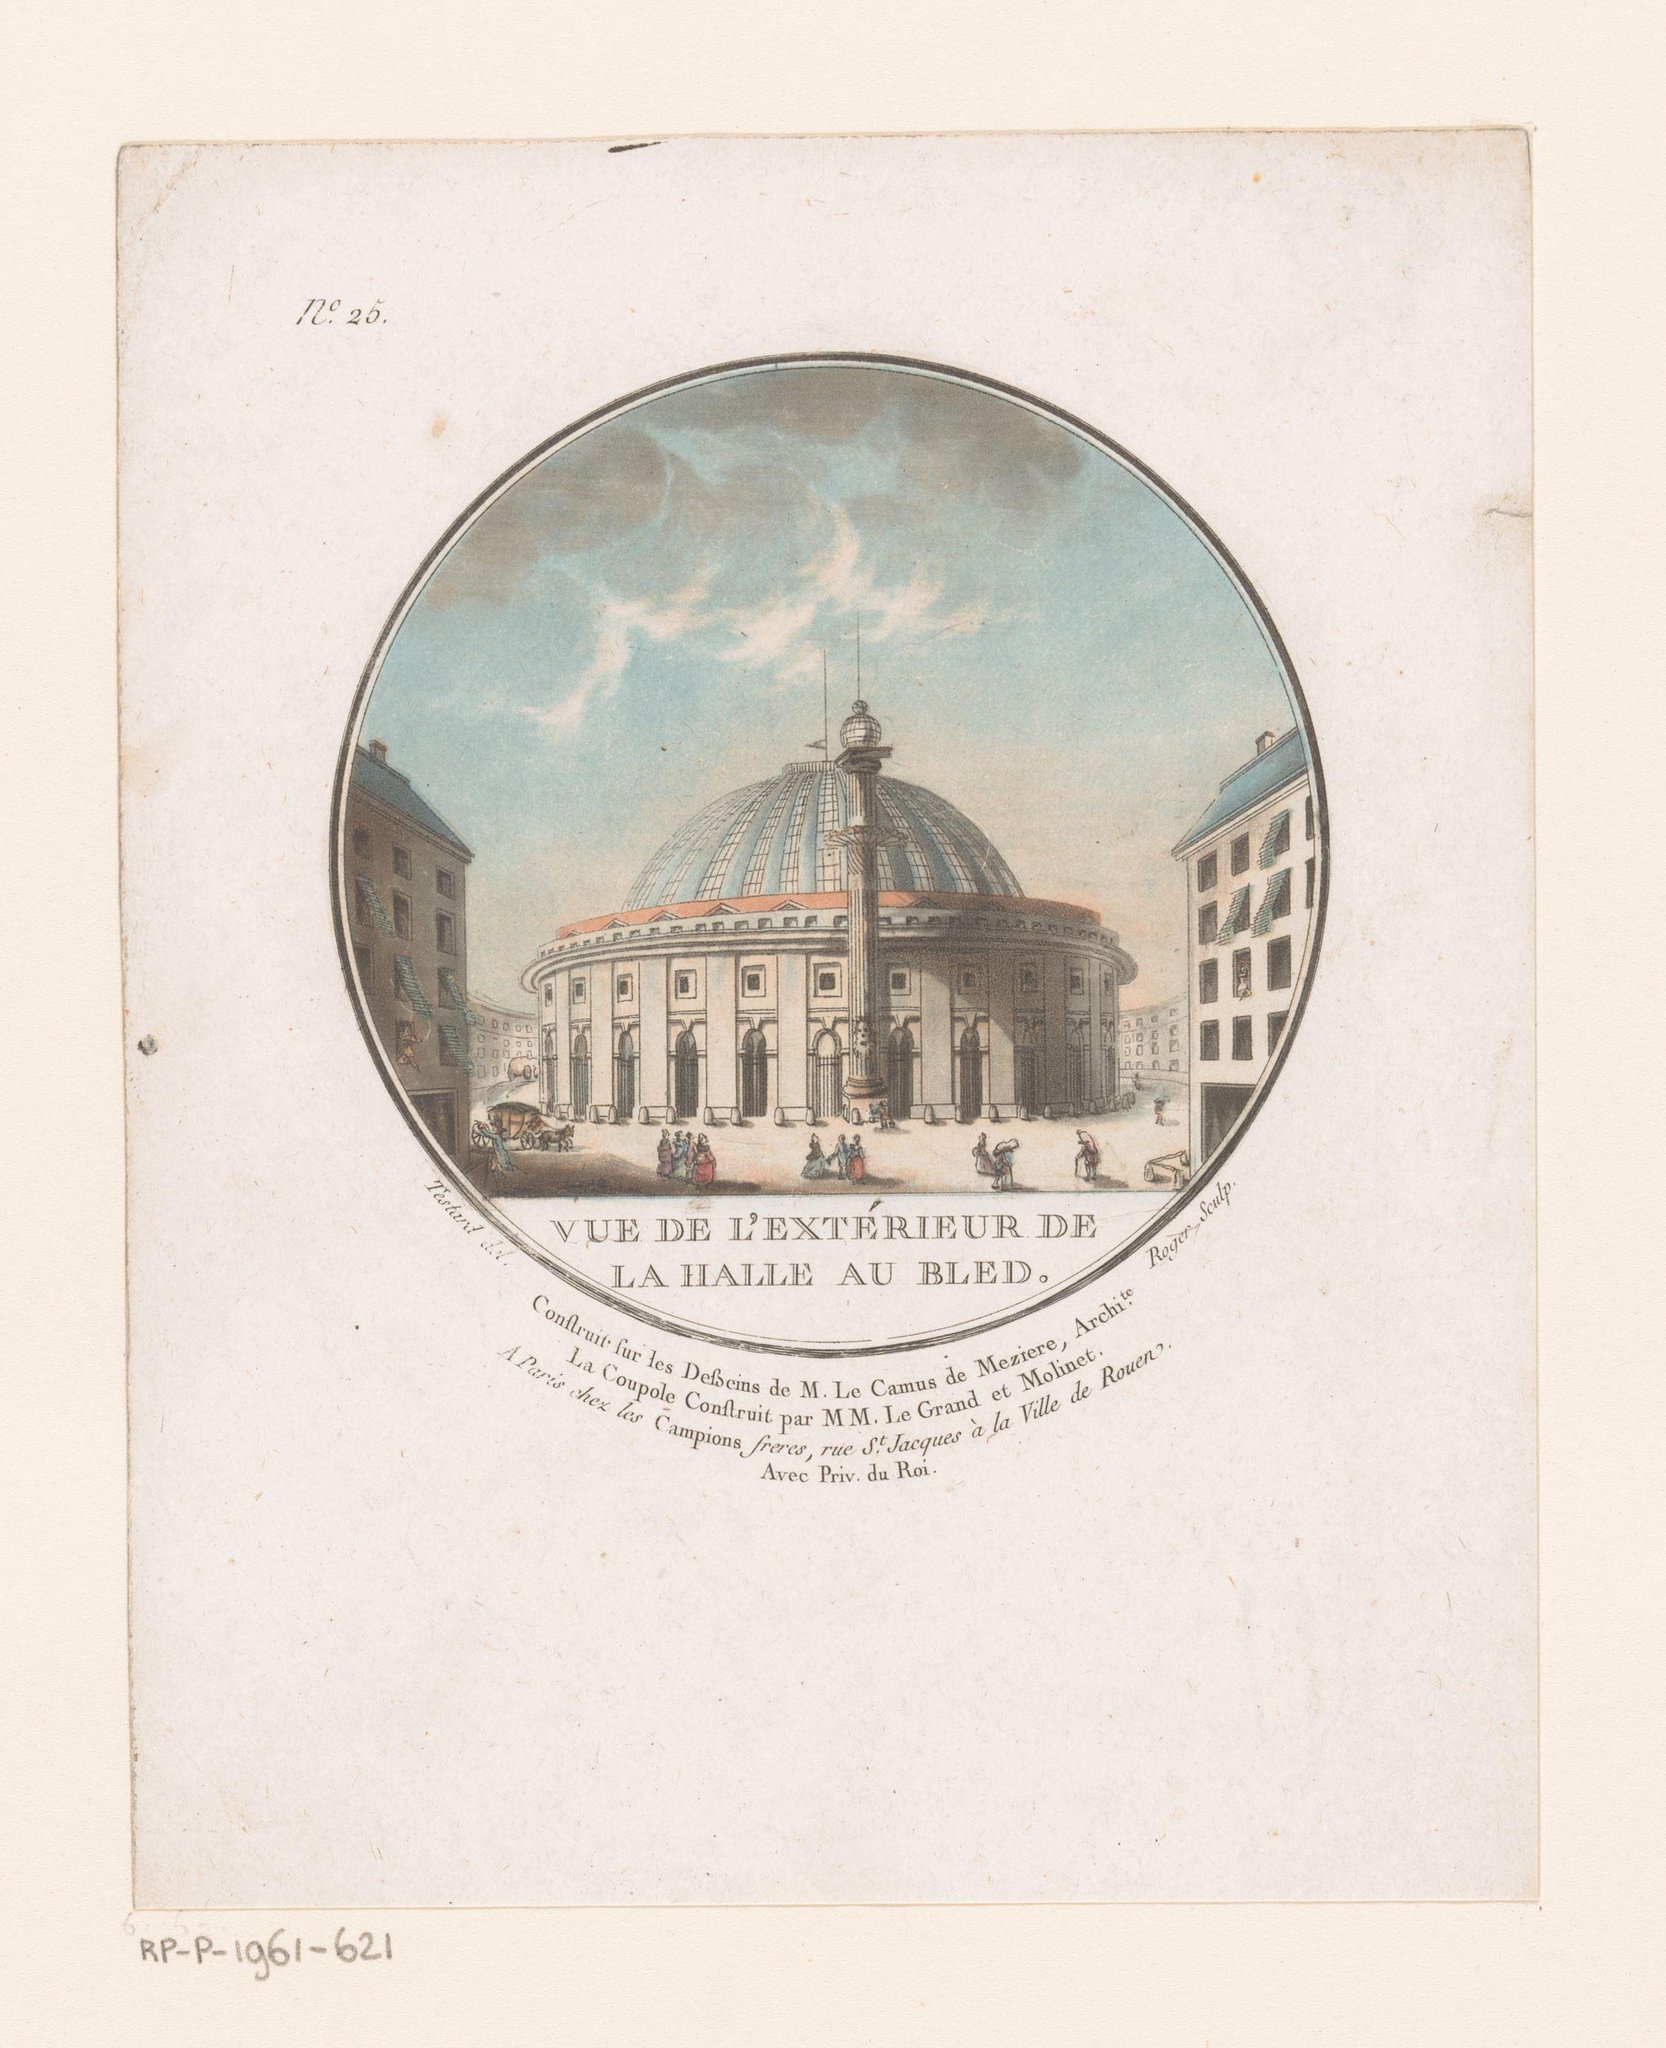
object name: print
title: Vues pittoresques des principaux edifices de Paris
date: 1789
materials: paper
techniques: aquatint, etching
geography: rouen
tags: city-view in general; 'veduta', paris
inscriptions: collector's mark: Lugt 2228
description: Prent maakt deel uit van een serie van 110 cirkelvormige aquatinten door Le Campion, Guyot, Roger, Guillot, Belley en Mlle Guyot naar F.M. Testard en Sergent.